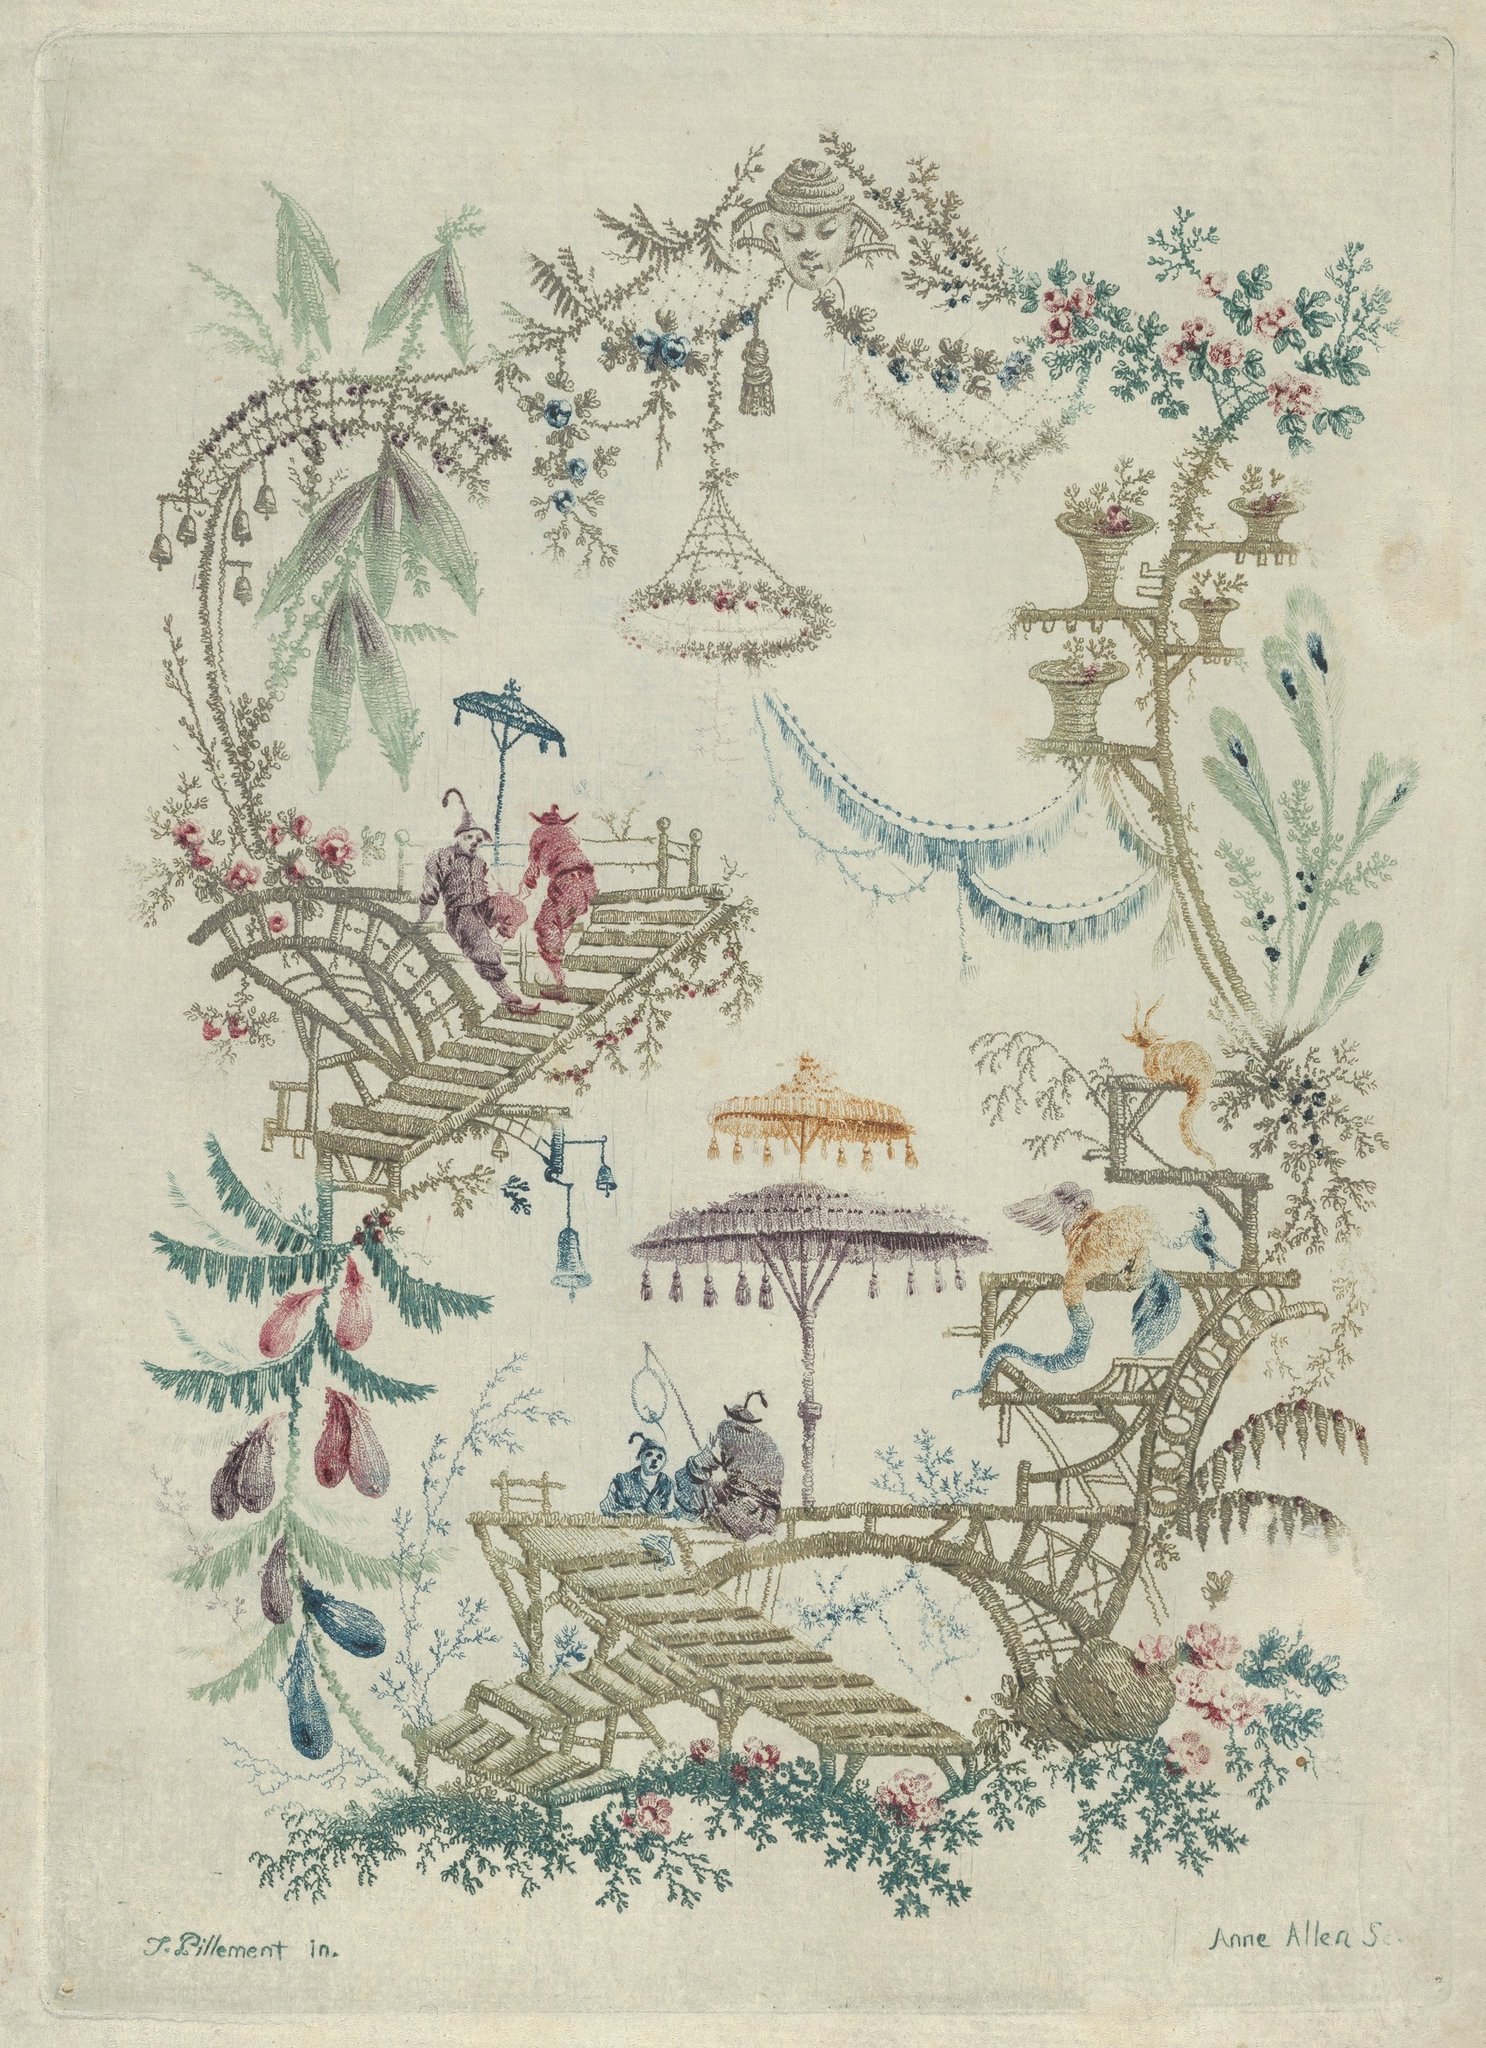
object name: print ornament architecture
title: Chinoiserie, from "Nouvelle Suite de Cahiers arabesques chinois a l'usage des dessinateurs et des peintres"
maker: jean pillement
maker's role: artist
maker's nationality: french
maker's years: 1728-1808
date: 1790-1799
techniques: etching, lithography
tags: birds,chinoiserie,men